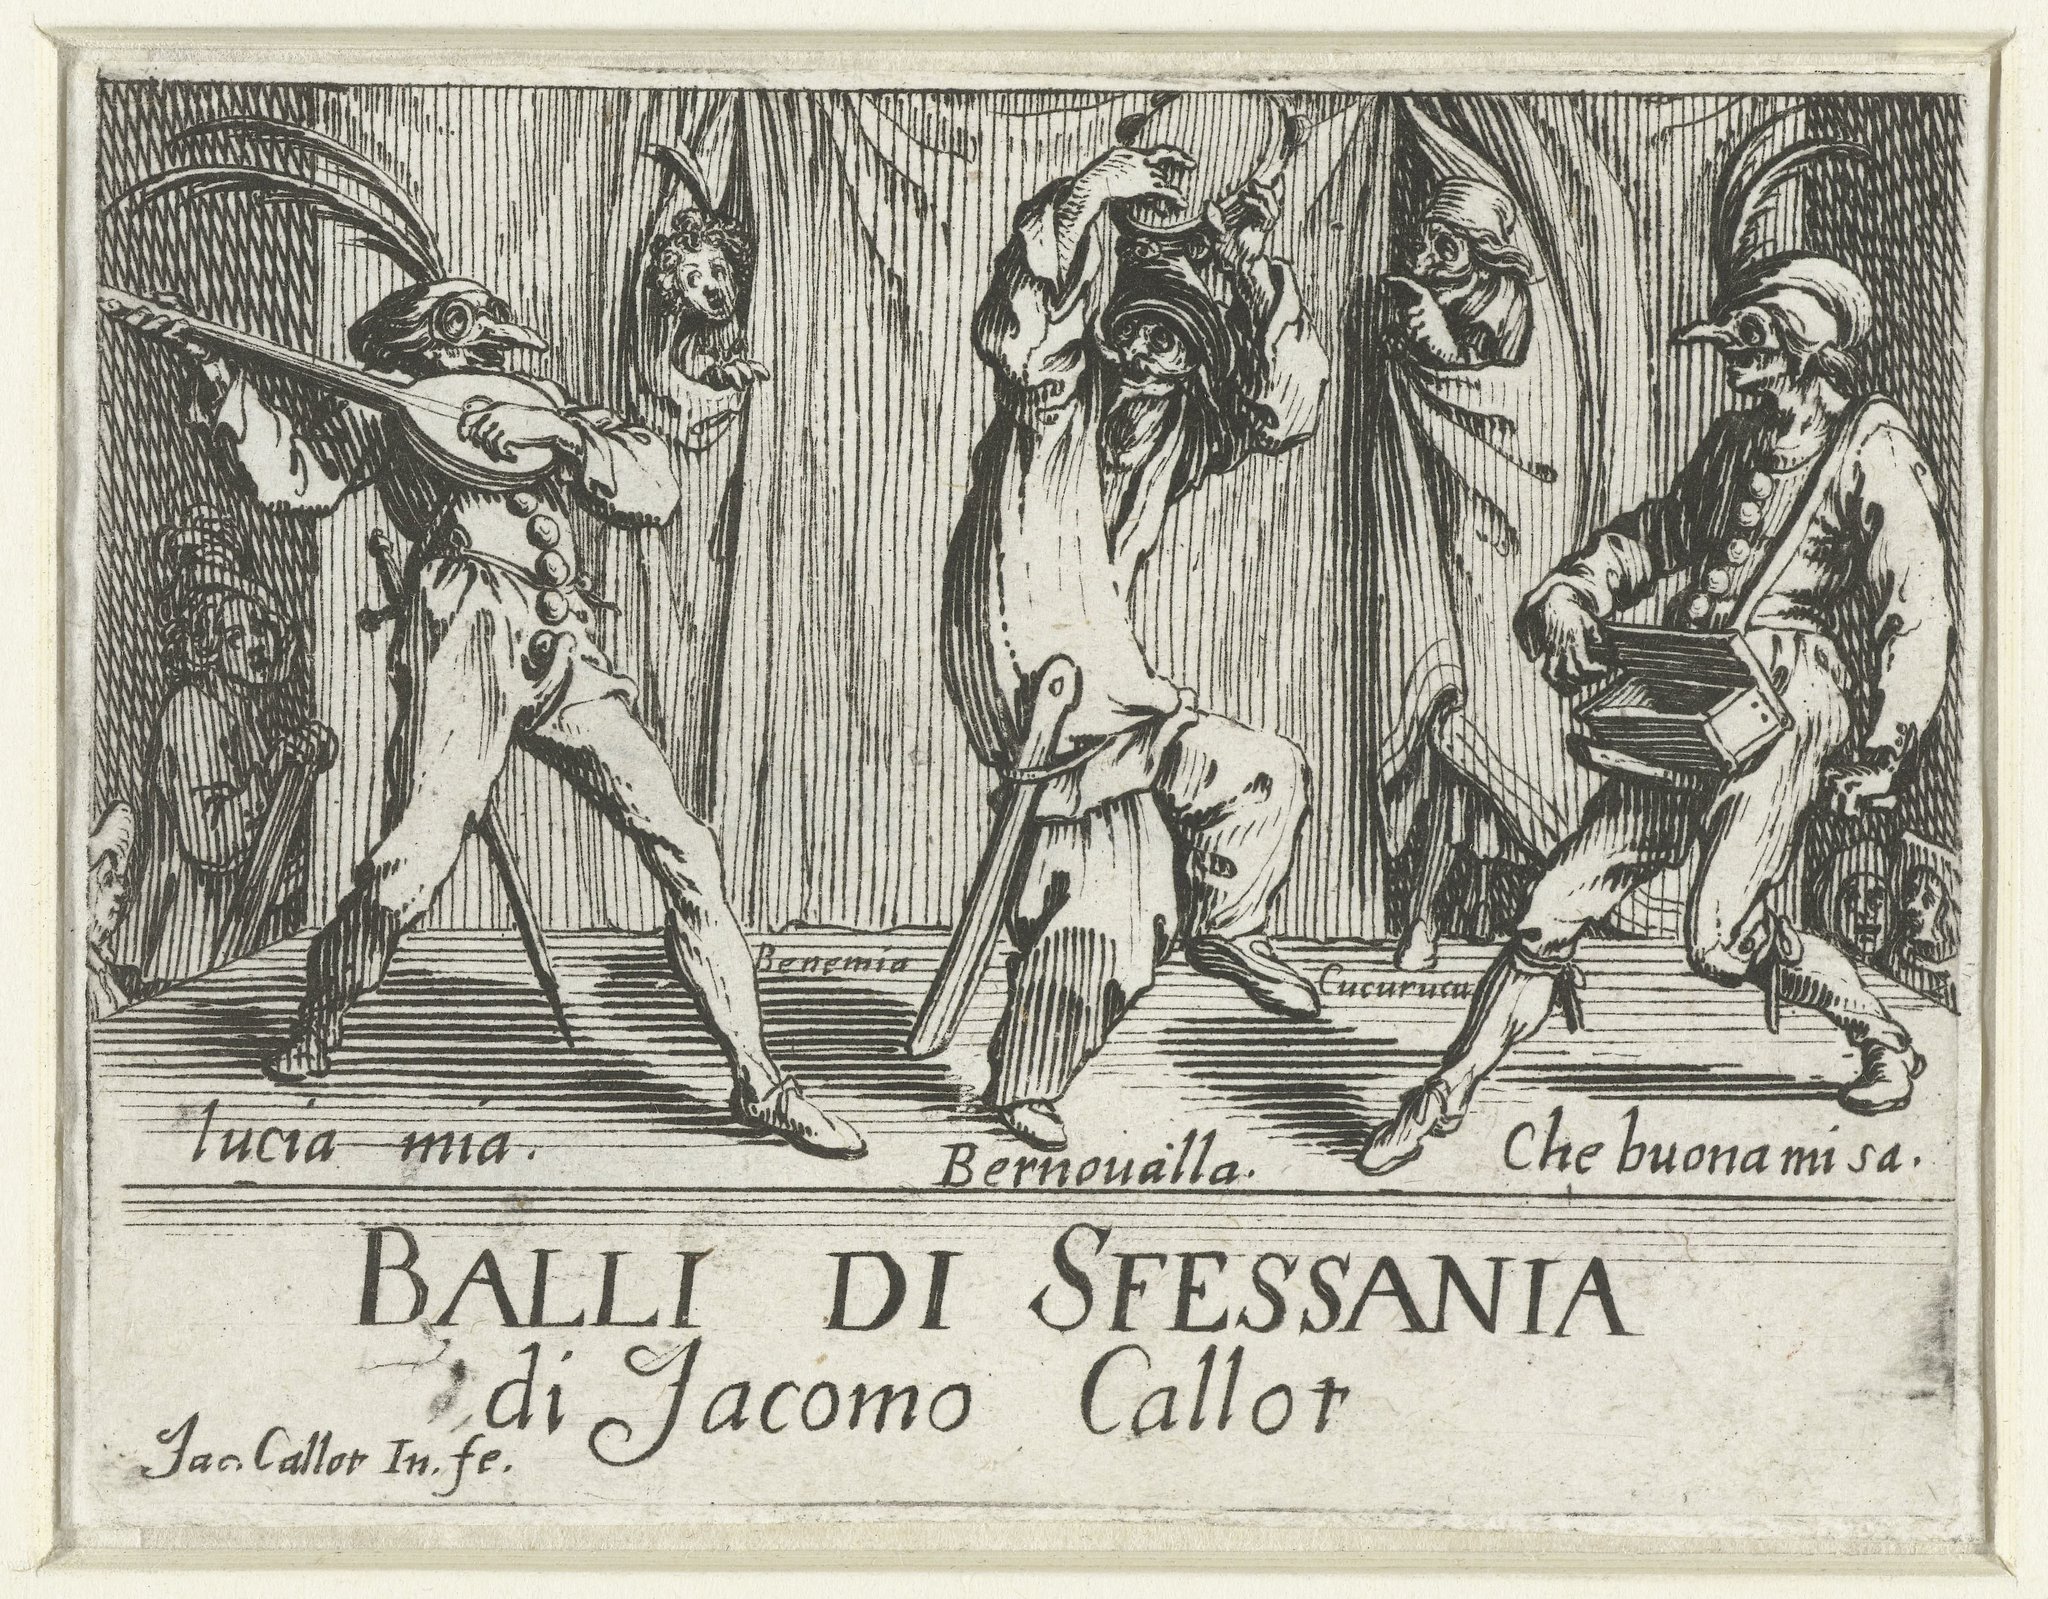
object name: titelprent, frontispice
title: Dansen van Sfessania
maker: jacques callot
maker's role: draughtsman, print maker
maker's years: 1592-1635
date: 1621-1622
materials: paper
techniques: engraving, etching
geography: nancy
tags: musician, types in 'commedia dell'arte', dancing, tambourine, string instruments (plucked)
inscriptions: collector's mark: Lugt 240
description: Op een toneel staan drie artiesten: een man met een luit of mandoline, een man met een tamboerijn en een man met een leeg kistje aan een band om zijn nek. Tussen de gordijnen op de achtergrond verschijnen nog twee spelers. Links en rechts zijn toeschouwers te zien. Onder de figuren en in de marge onder de voorstelling staan Italiaanse teksten. Dit is de titelprent voor een serie van 23 prenten met telkens op de voorgrond twee straatartiesten verkleed als figuren uit de Italiaanse commedia dell'arte, en op de achtergrond toeschouwers die in de buitenlucht een (dans)voorstelling van straatartiesten gadeslaan.